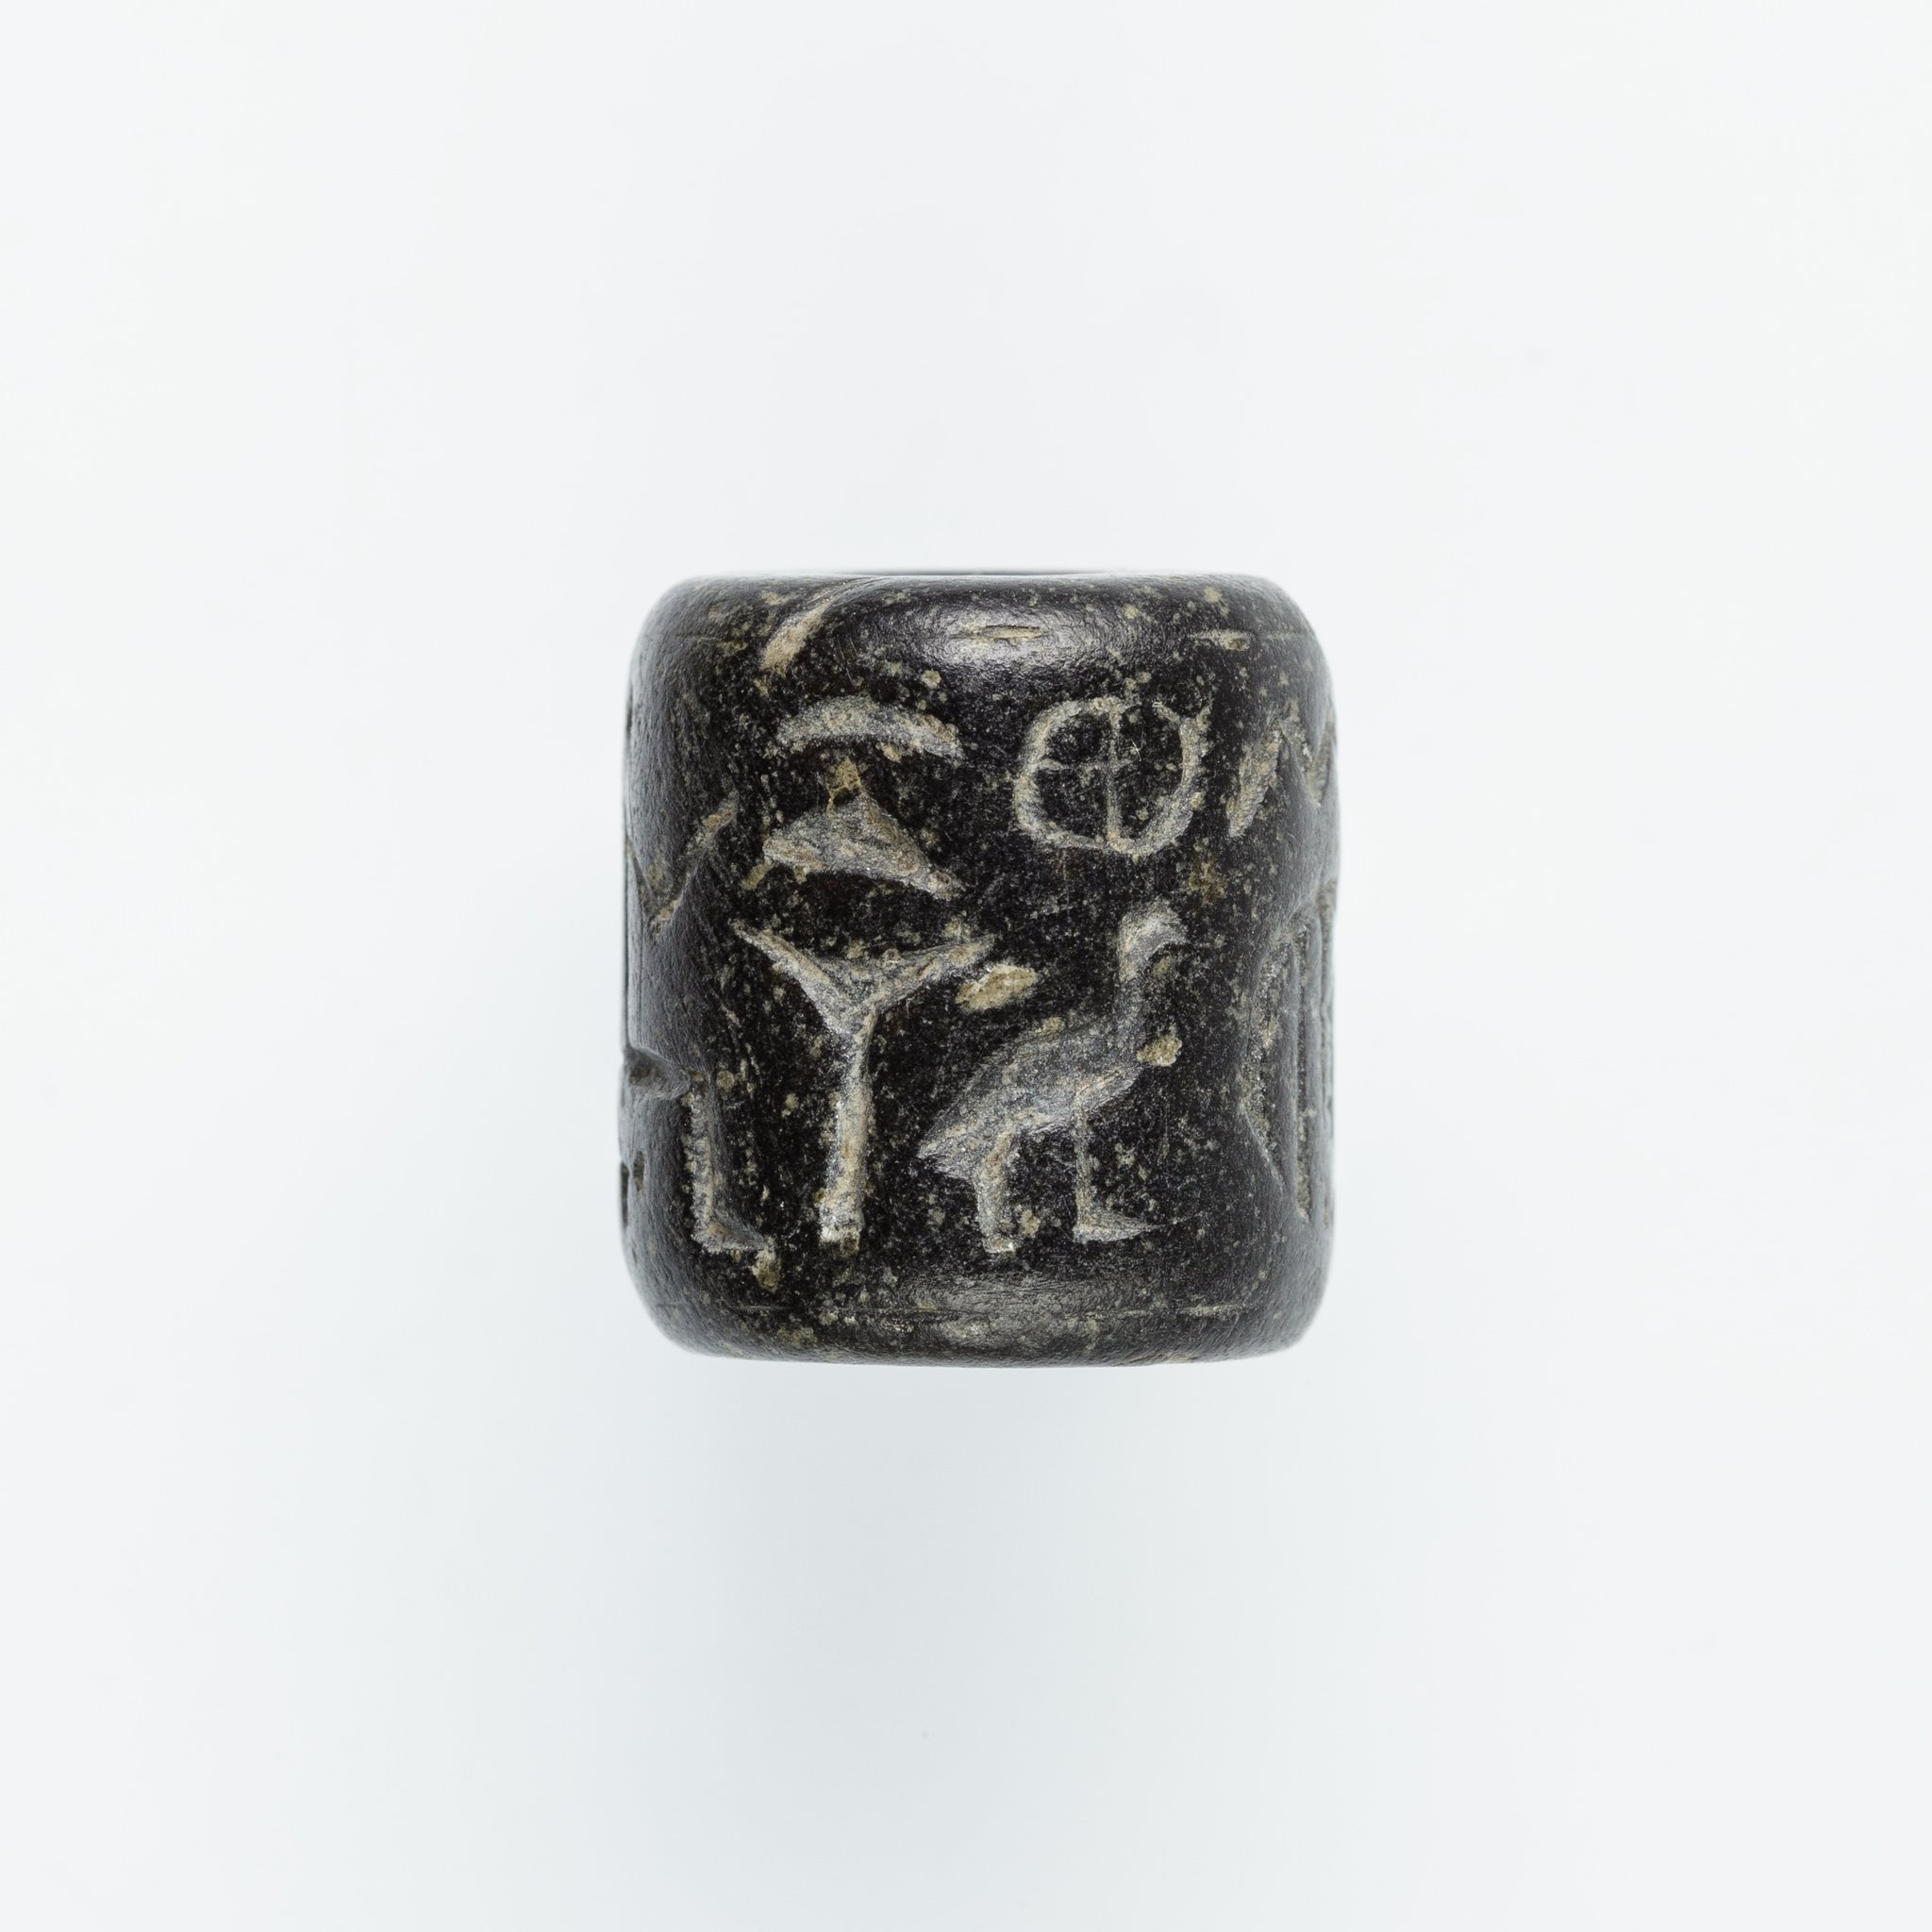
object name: cylinder seal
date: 2960-2649 BCE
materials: stone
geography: egypt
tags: hieroglyphs